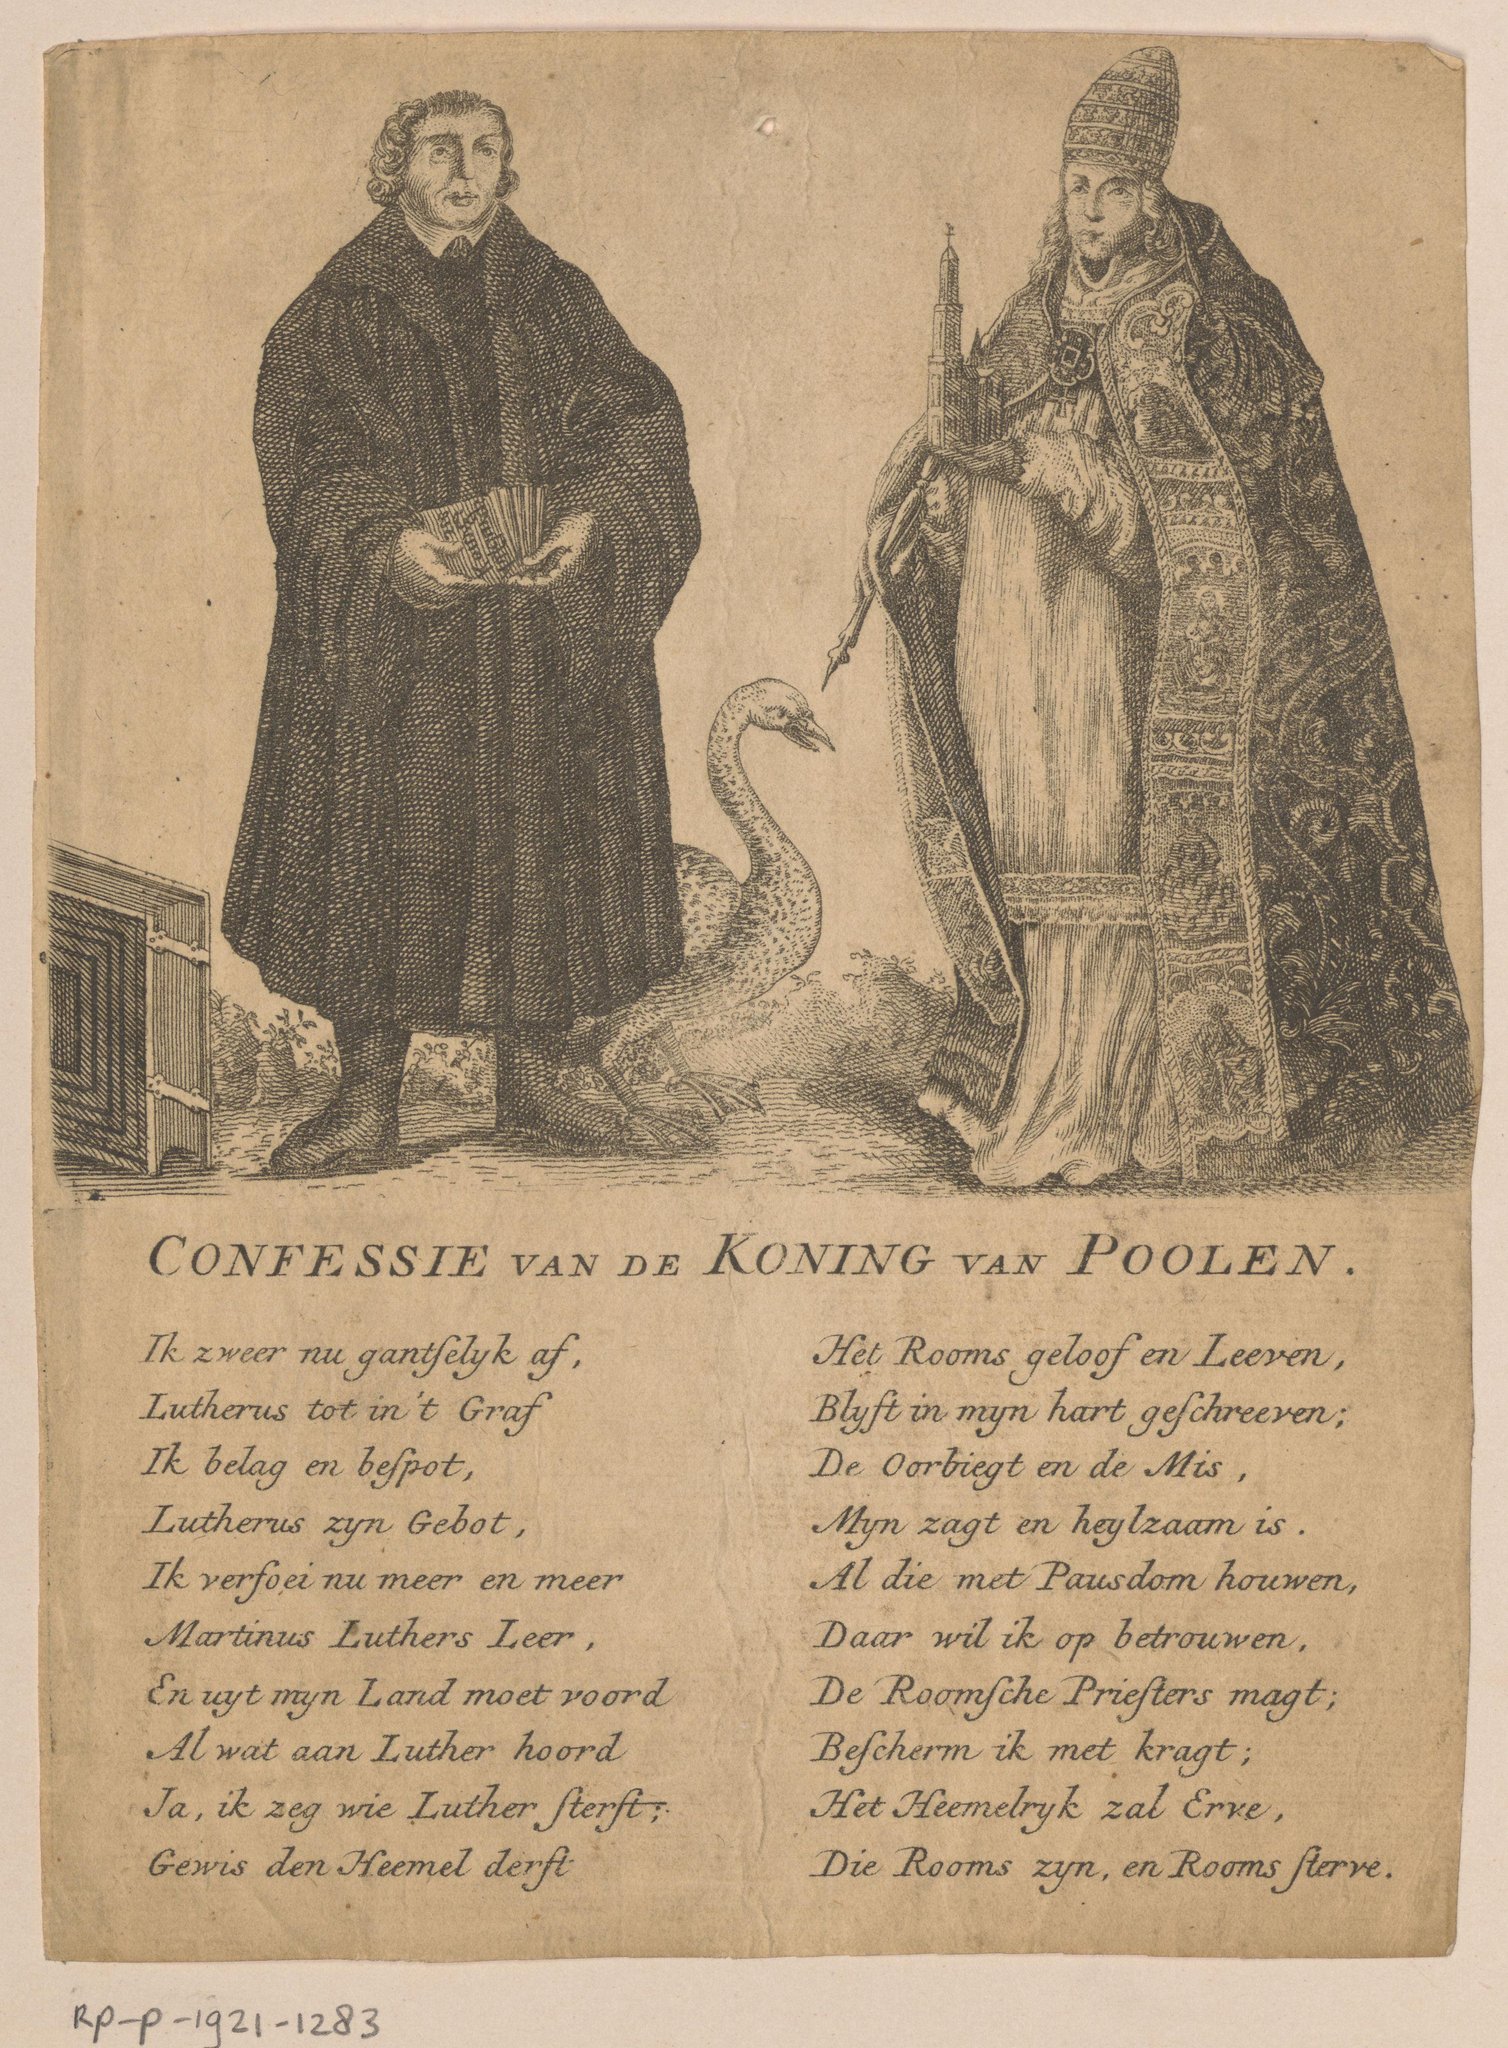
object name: print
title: Confessie van de Koning van Poolen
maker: Anonymous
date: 1700-1750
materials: paper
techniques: etching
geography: northern netherlands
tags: hendrik iii (koning van frankrijk), priest, martin luther, protestant churches and denominations, water-birds: swan, historical persons, roman catholic church, king, political caricatures and satires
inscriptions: collector's mark: Lugt 2233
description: De eerste kolom is een afwijzing van Luthers leer door de Poolse koning, de tweede kolom een lofdicht op het katholieke geloof. Als de twee kolommen echter als één regel worden gelezen, dan is het vers een lofdicht op Luthers leer en een afwijzing van het katholieke geloof. Zie ook Atlas van Stolk. Vermoedelijk is de Poolse koning Hendrik III van Frankrijk, in 1573-1574 koning van Polen.